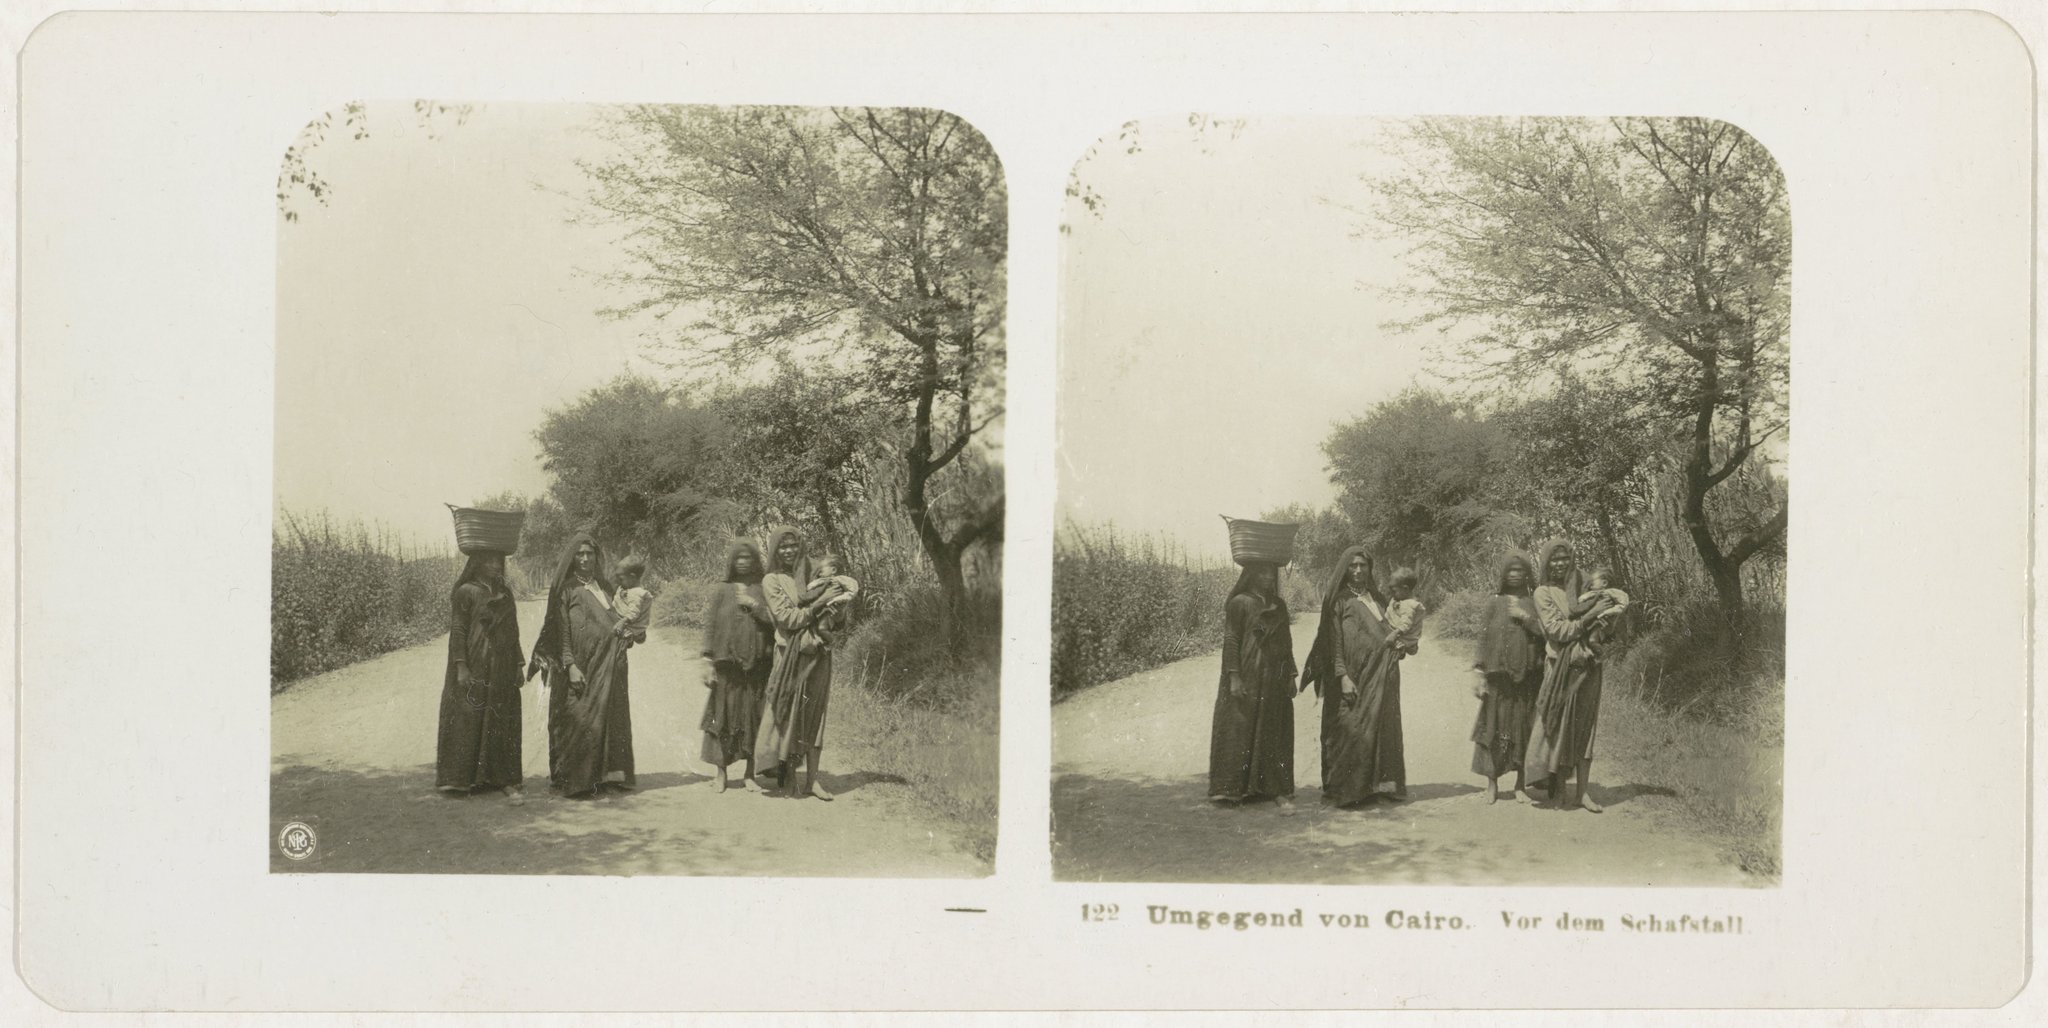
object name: stereograph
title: Vier vrouwen met twee kinderen op een landweg nabij Caïro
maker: Anonymous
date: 1909-1935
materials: paper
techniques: gelatin silver print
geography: cairo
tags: walking - aa - female human figure (+ four persons), road, path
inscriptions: number: ‘122’